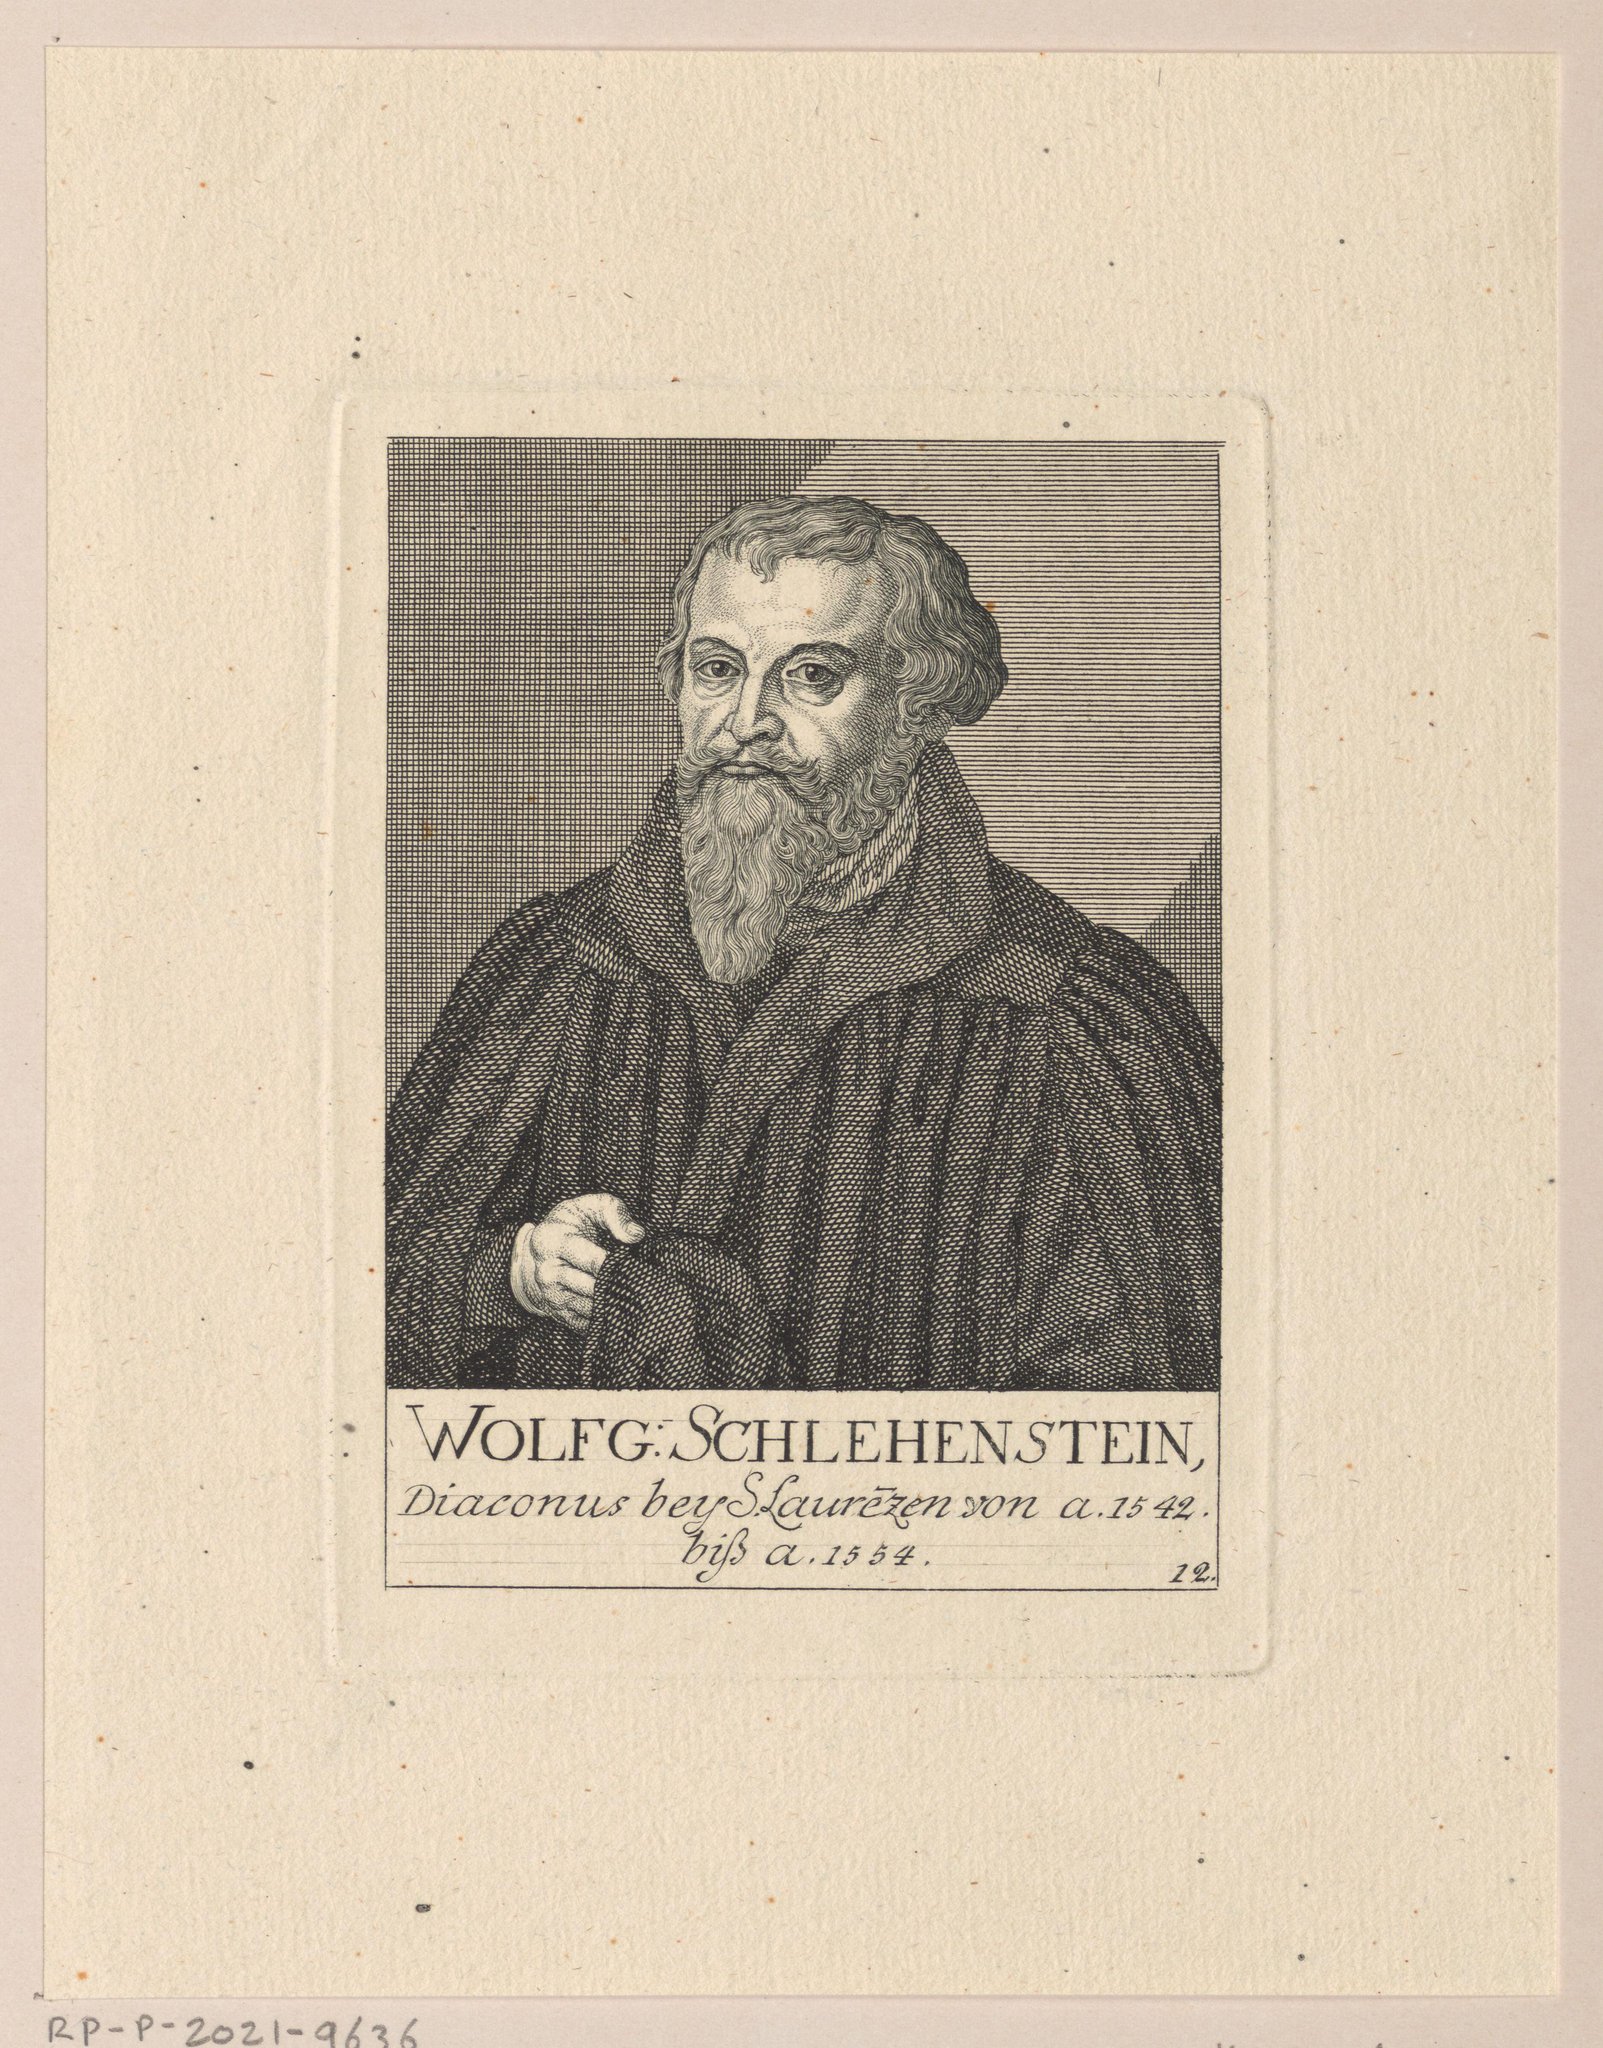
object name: print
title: Portret van Wolfgang Schlehenstein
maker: Anonymous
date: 1756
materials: paper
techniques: engraving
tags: historical persons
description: Prent mogelijk uit: Würfel, Andreas. Diptycha ecclesiae Laurentianae (...). Neurenberg: Christoph Melchior Roth, 1756.